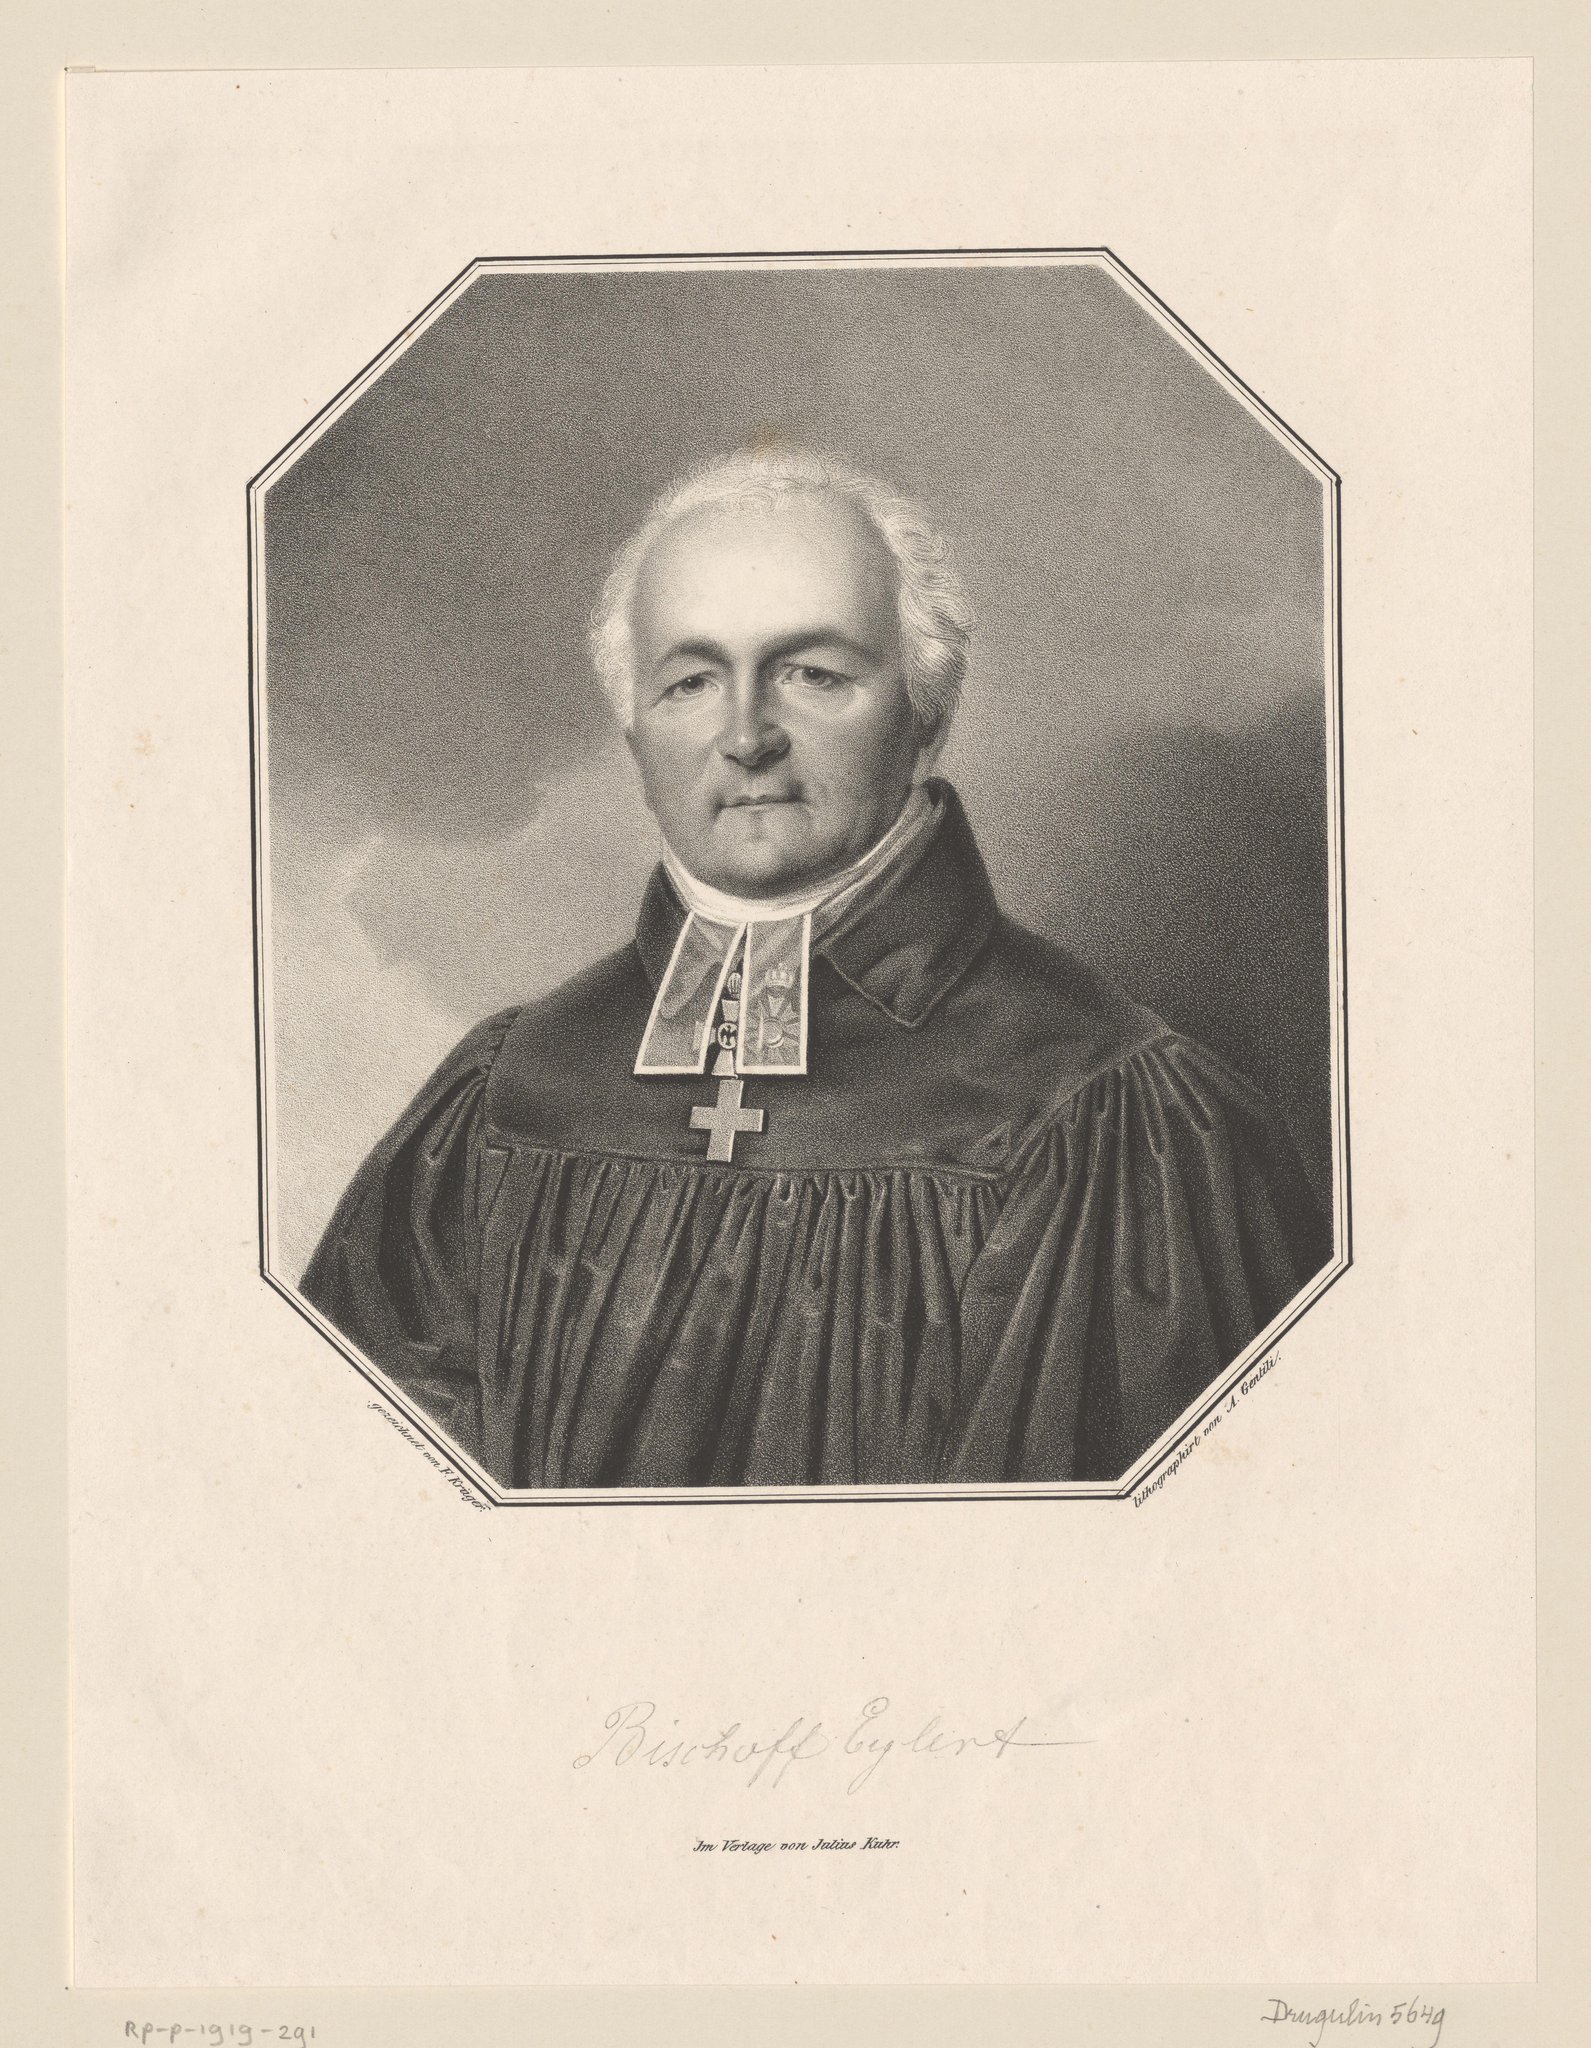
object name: print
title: Portret van Rulemann Friedrich Eylert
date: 1826-1840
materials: paper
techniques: lithograph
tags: archbishop, bishop, etc. (roman catholic), historical persons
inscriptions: inscription: ‘Bischoff Eylert’, collector's mark: Lugt 2228